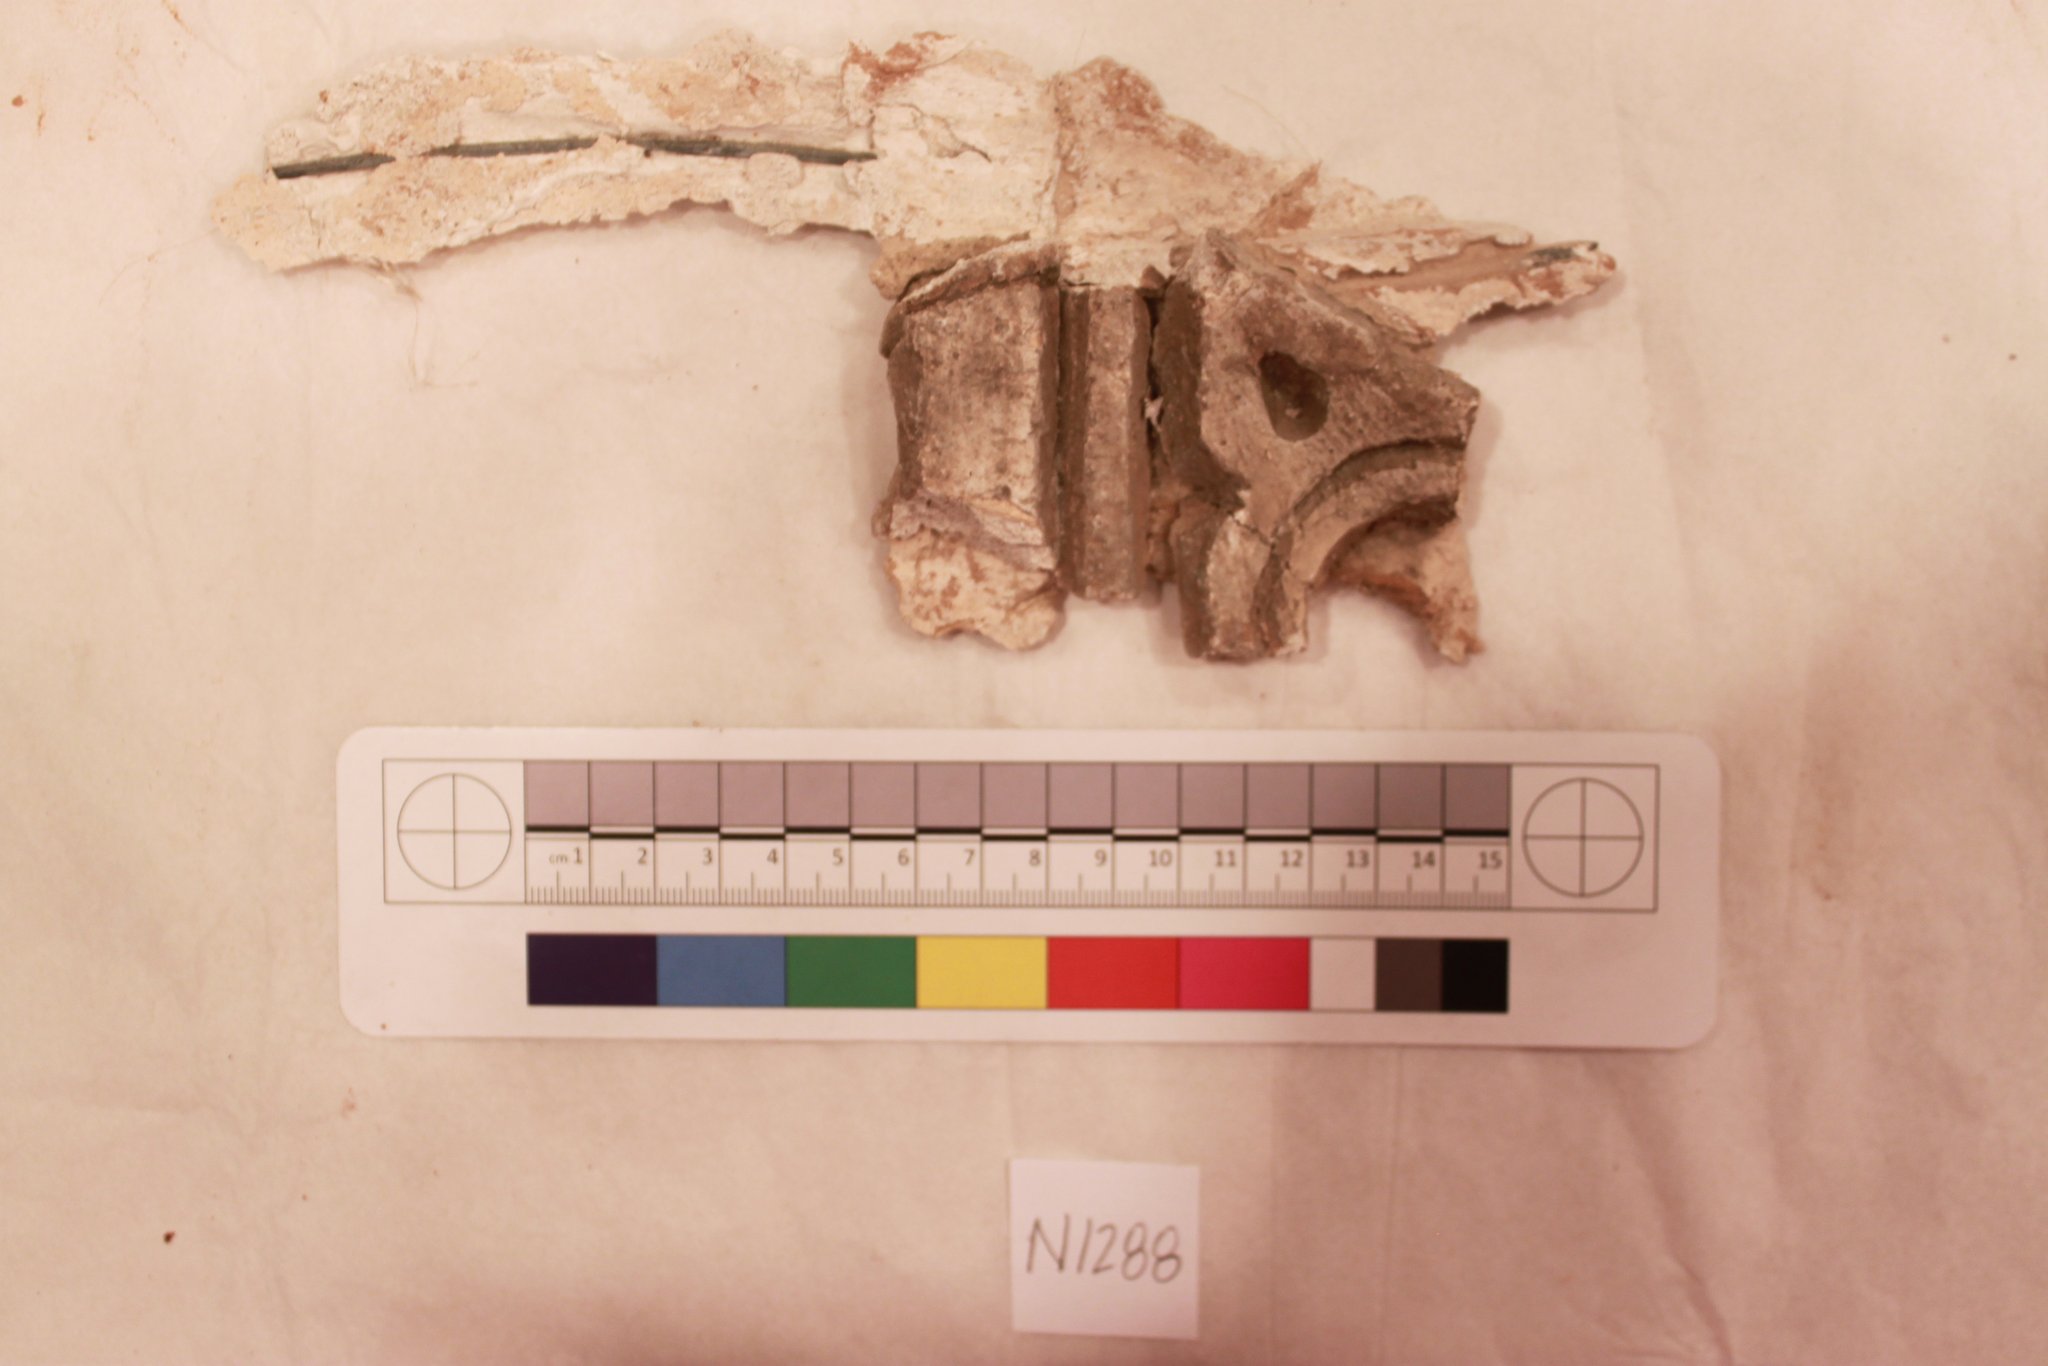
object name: fragment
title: Stucco Fragment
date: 701-1200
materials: plaster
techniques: carving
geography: iran